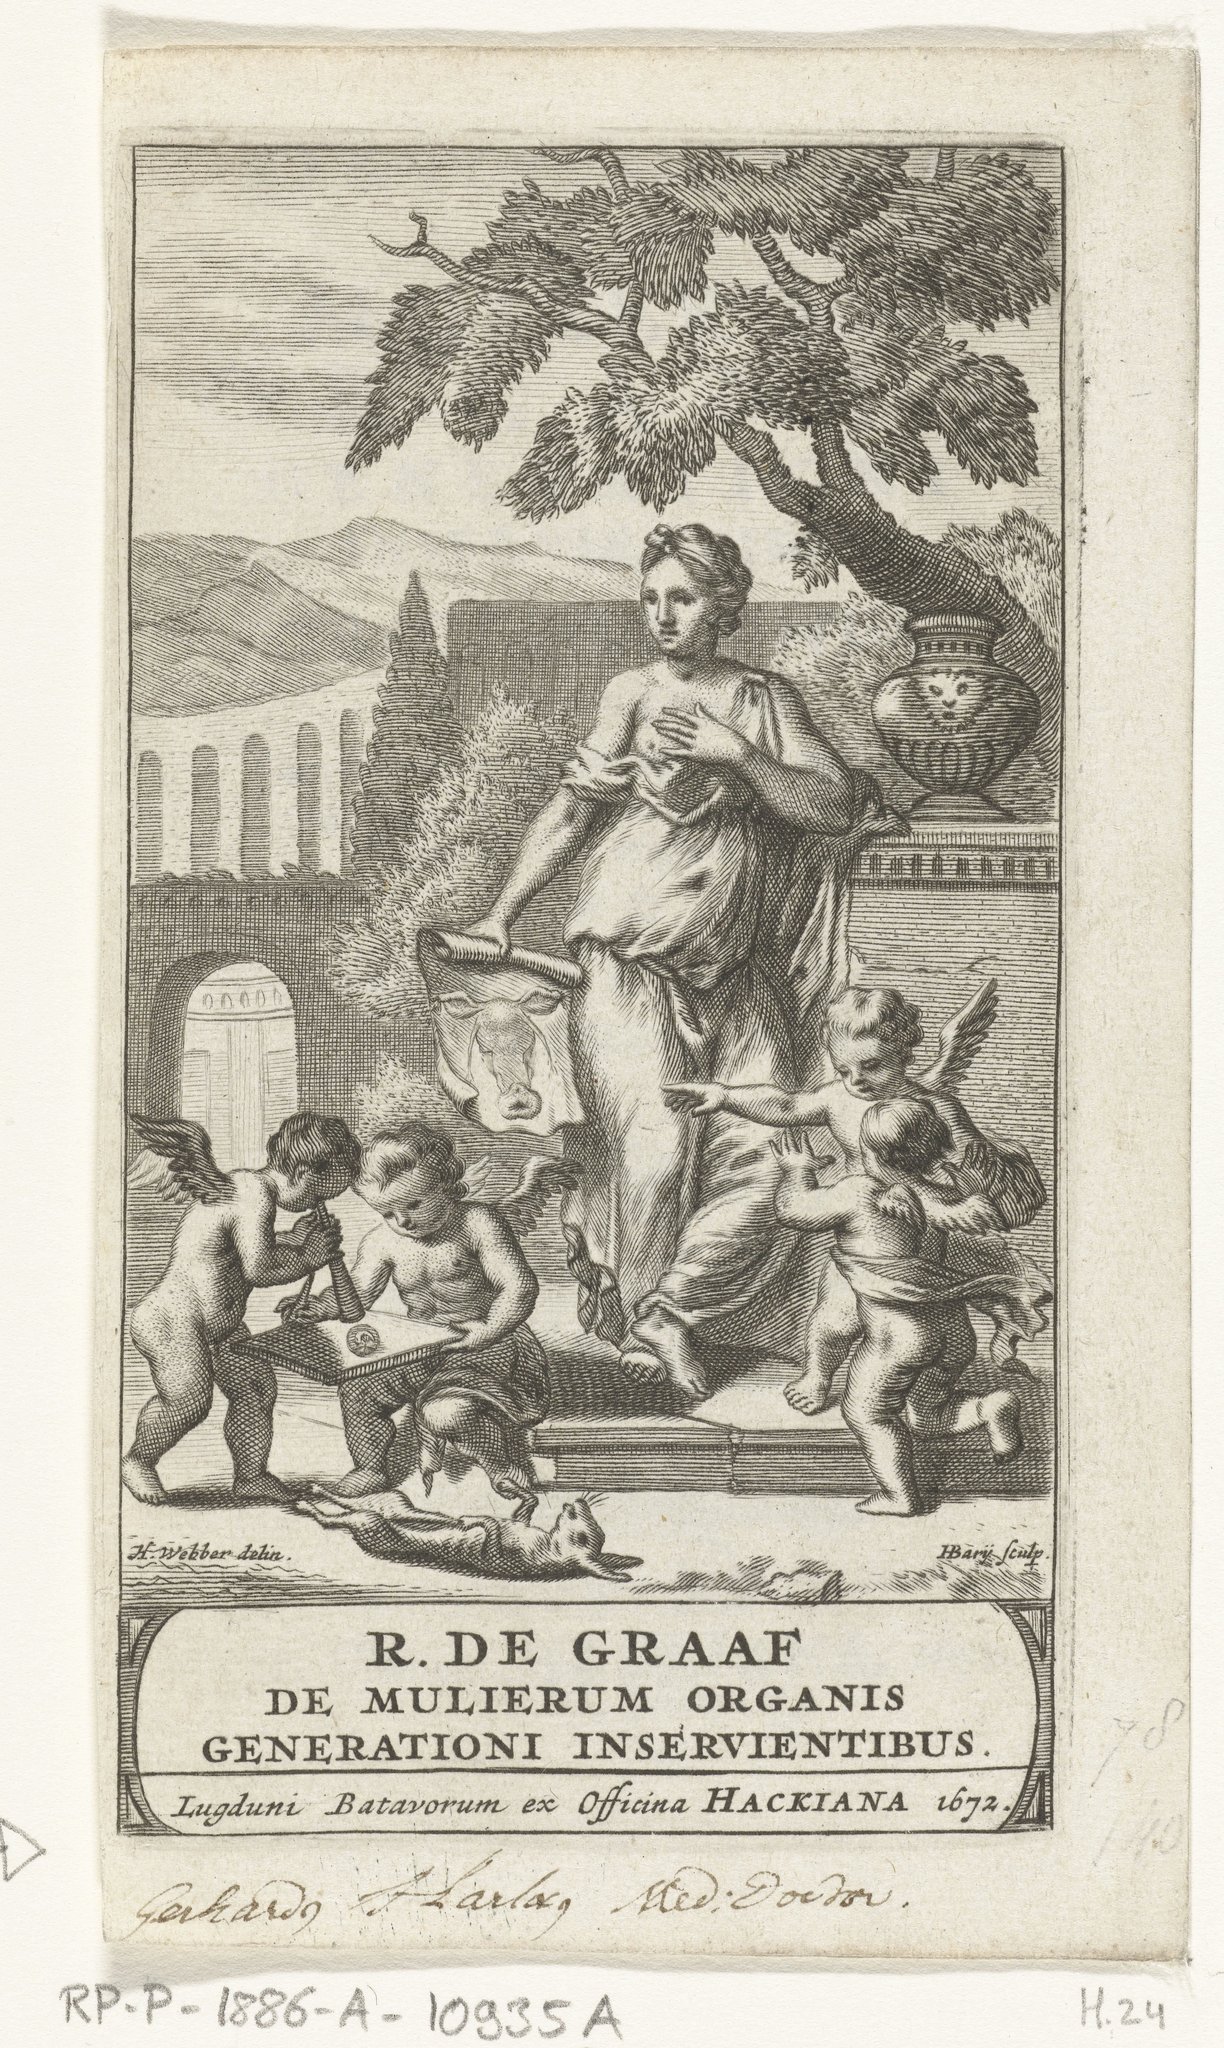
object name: print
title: Prints of the Female Reproductive Organs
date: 1672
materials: paper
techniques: engraving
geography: netherlands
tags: anatomy lesson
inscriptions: collector's mark: Lugt 2228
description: In 1672, physician and anatomist Reinier de Graaf published his De mulierum organis about the female reproductive organs. The book contains detailed prints by Hendrik Bary, among them several of the vagina. De Graaf was the first to conclude that a foetus was the product not just of a man’s seed, but also of a woman’s egg. He discovered what he called blisters, which later became known as Graafian follicles.